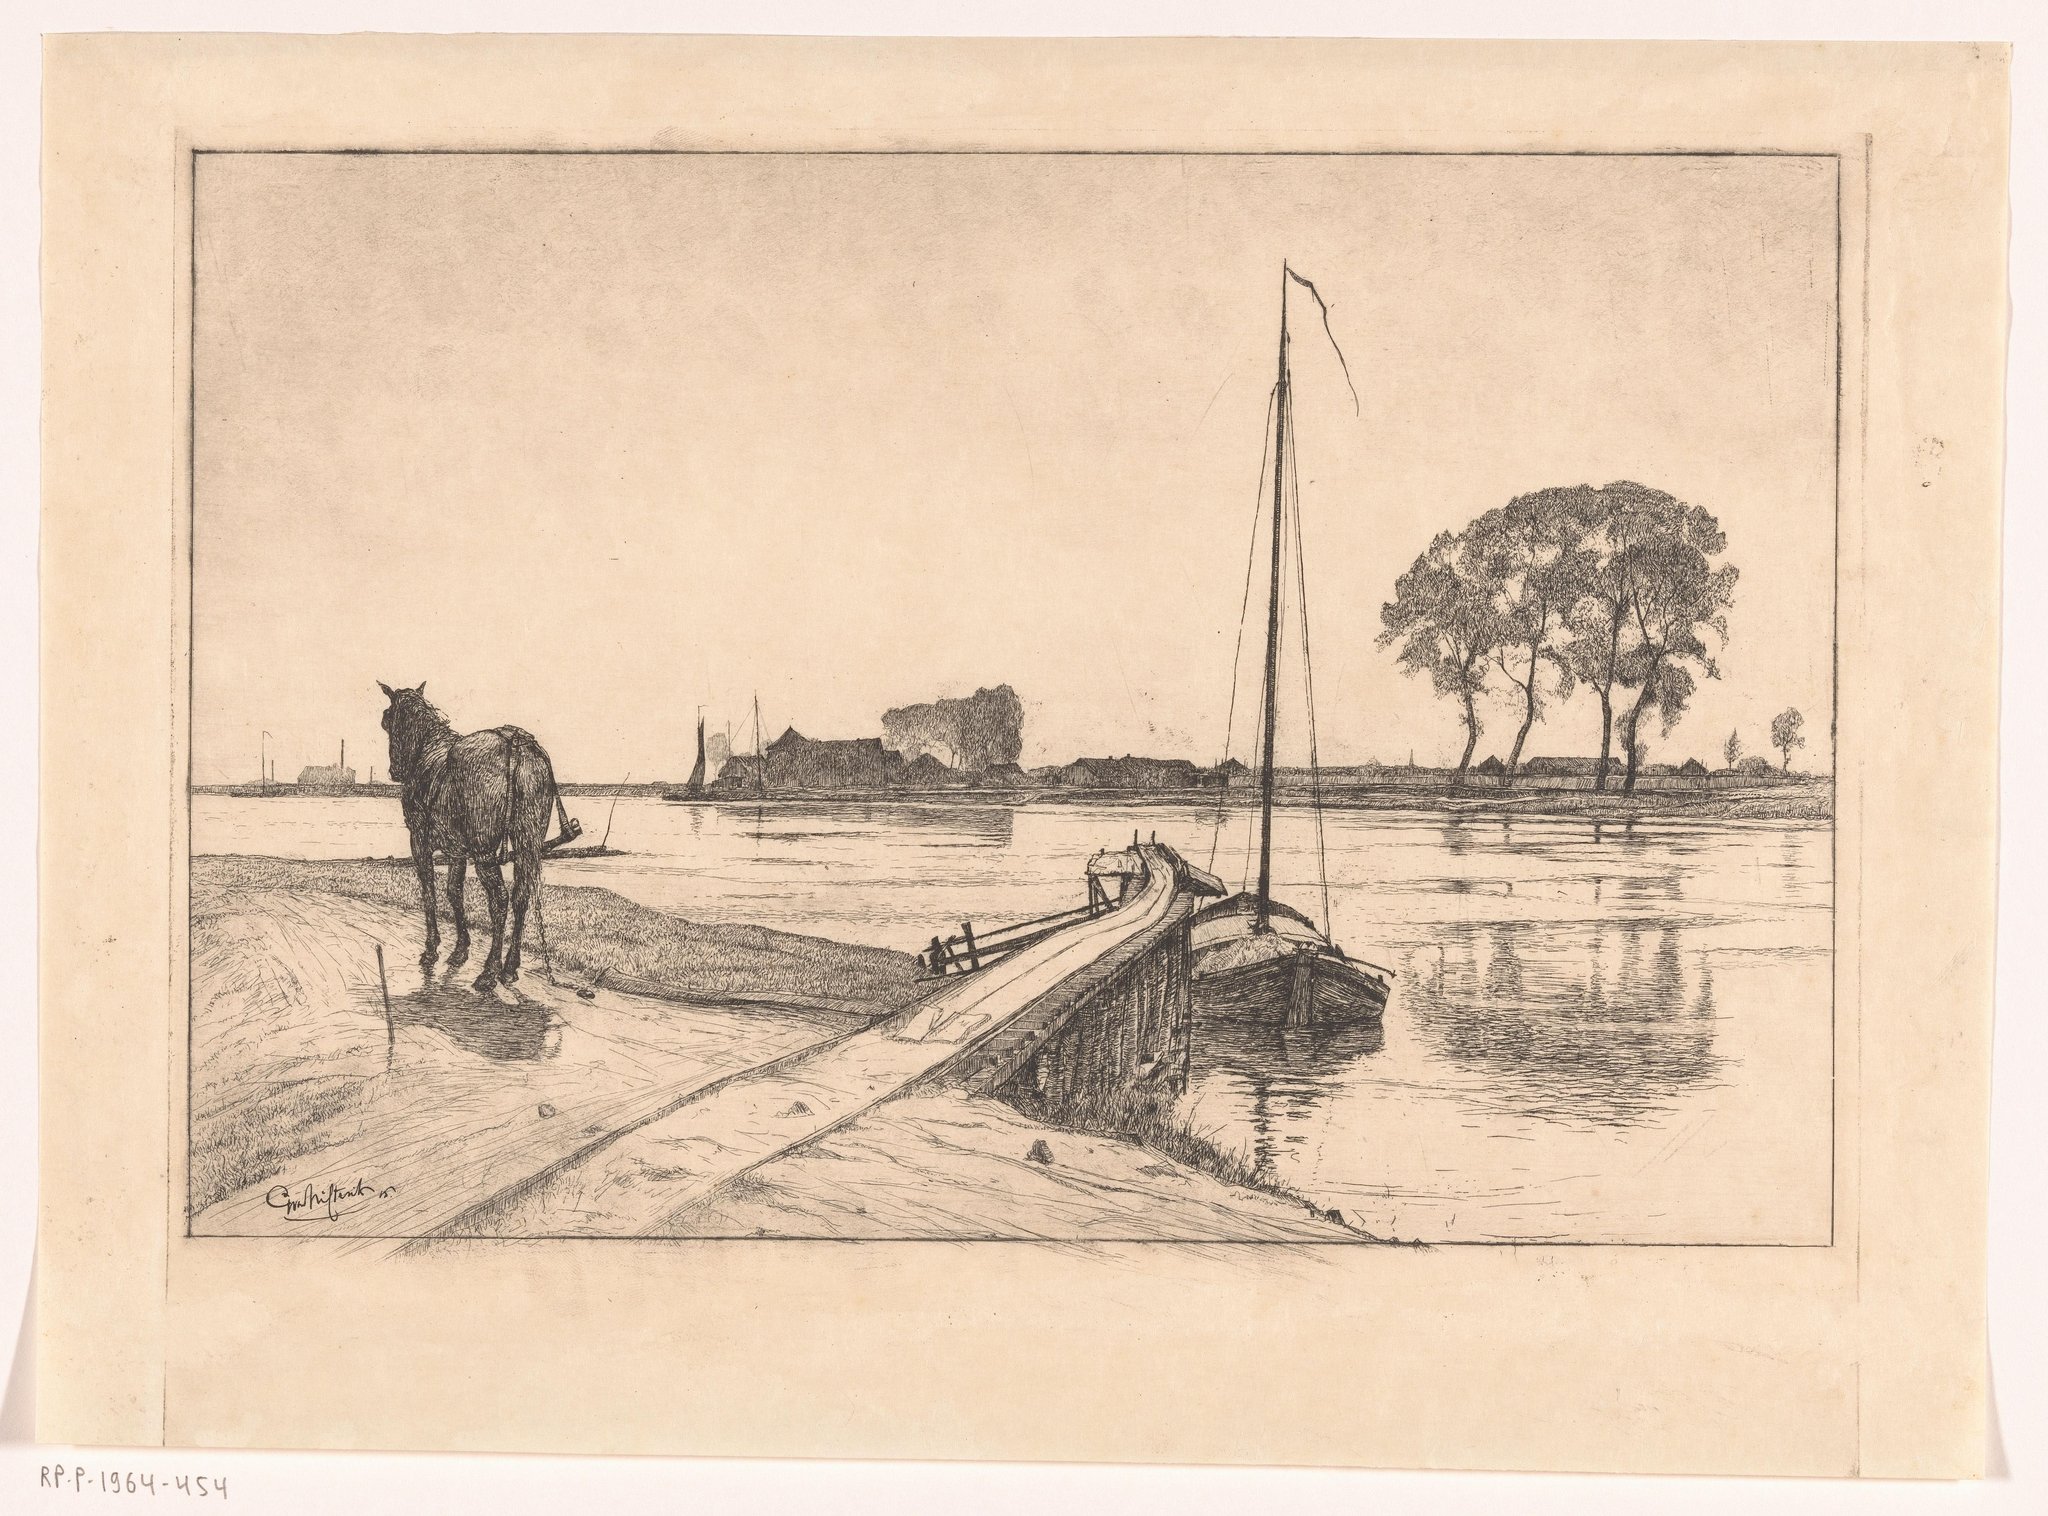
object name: print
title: Paard met sleepgerei bij een steiger in een rivier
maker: gustaaf van nifterik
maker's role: print maker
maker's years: 1886-1954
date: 1915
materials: paper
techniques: etching, intaglio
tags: sailing-ship, sailing-boat, river, horse, farm or solitary house in landscape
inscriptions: collector's mark: Lugt 2228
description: Bij de steiger is een zeilschip afgemeerd. Op de achtergrond het silhouet van meerdere zeilschepen en boerderijen.